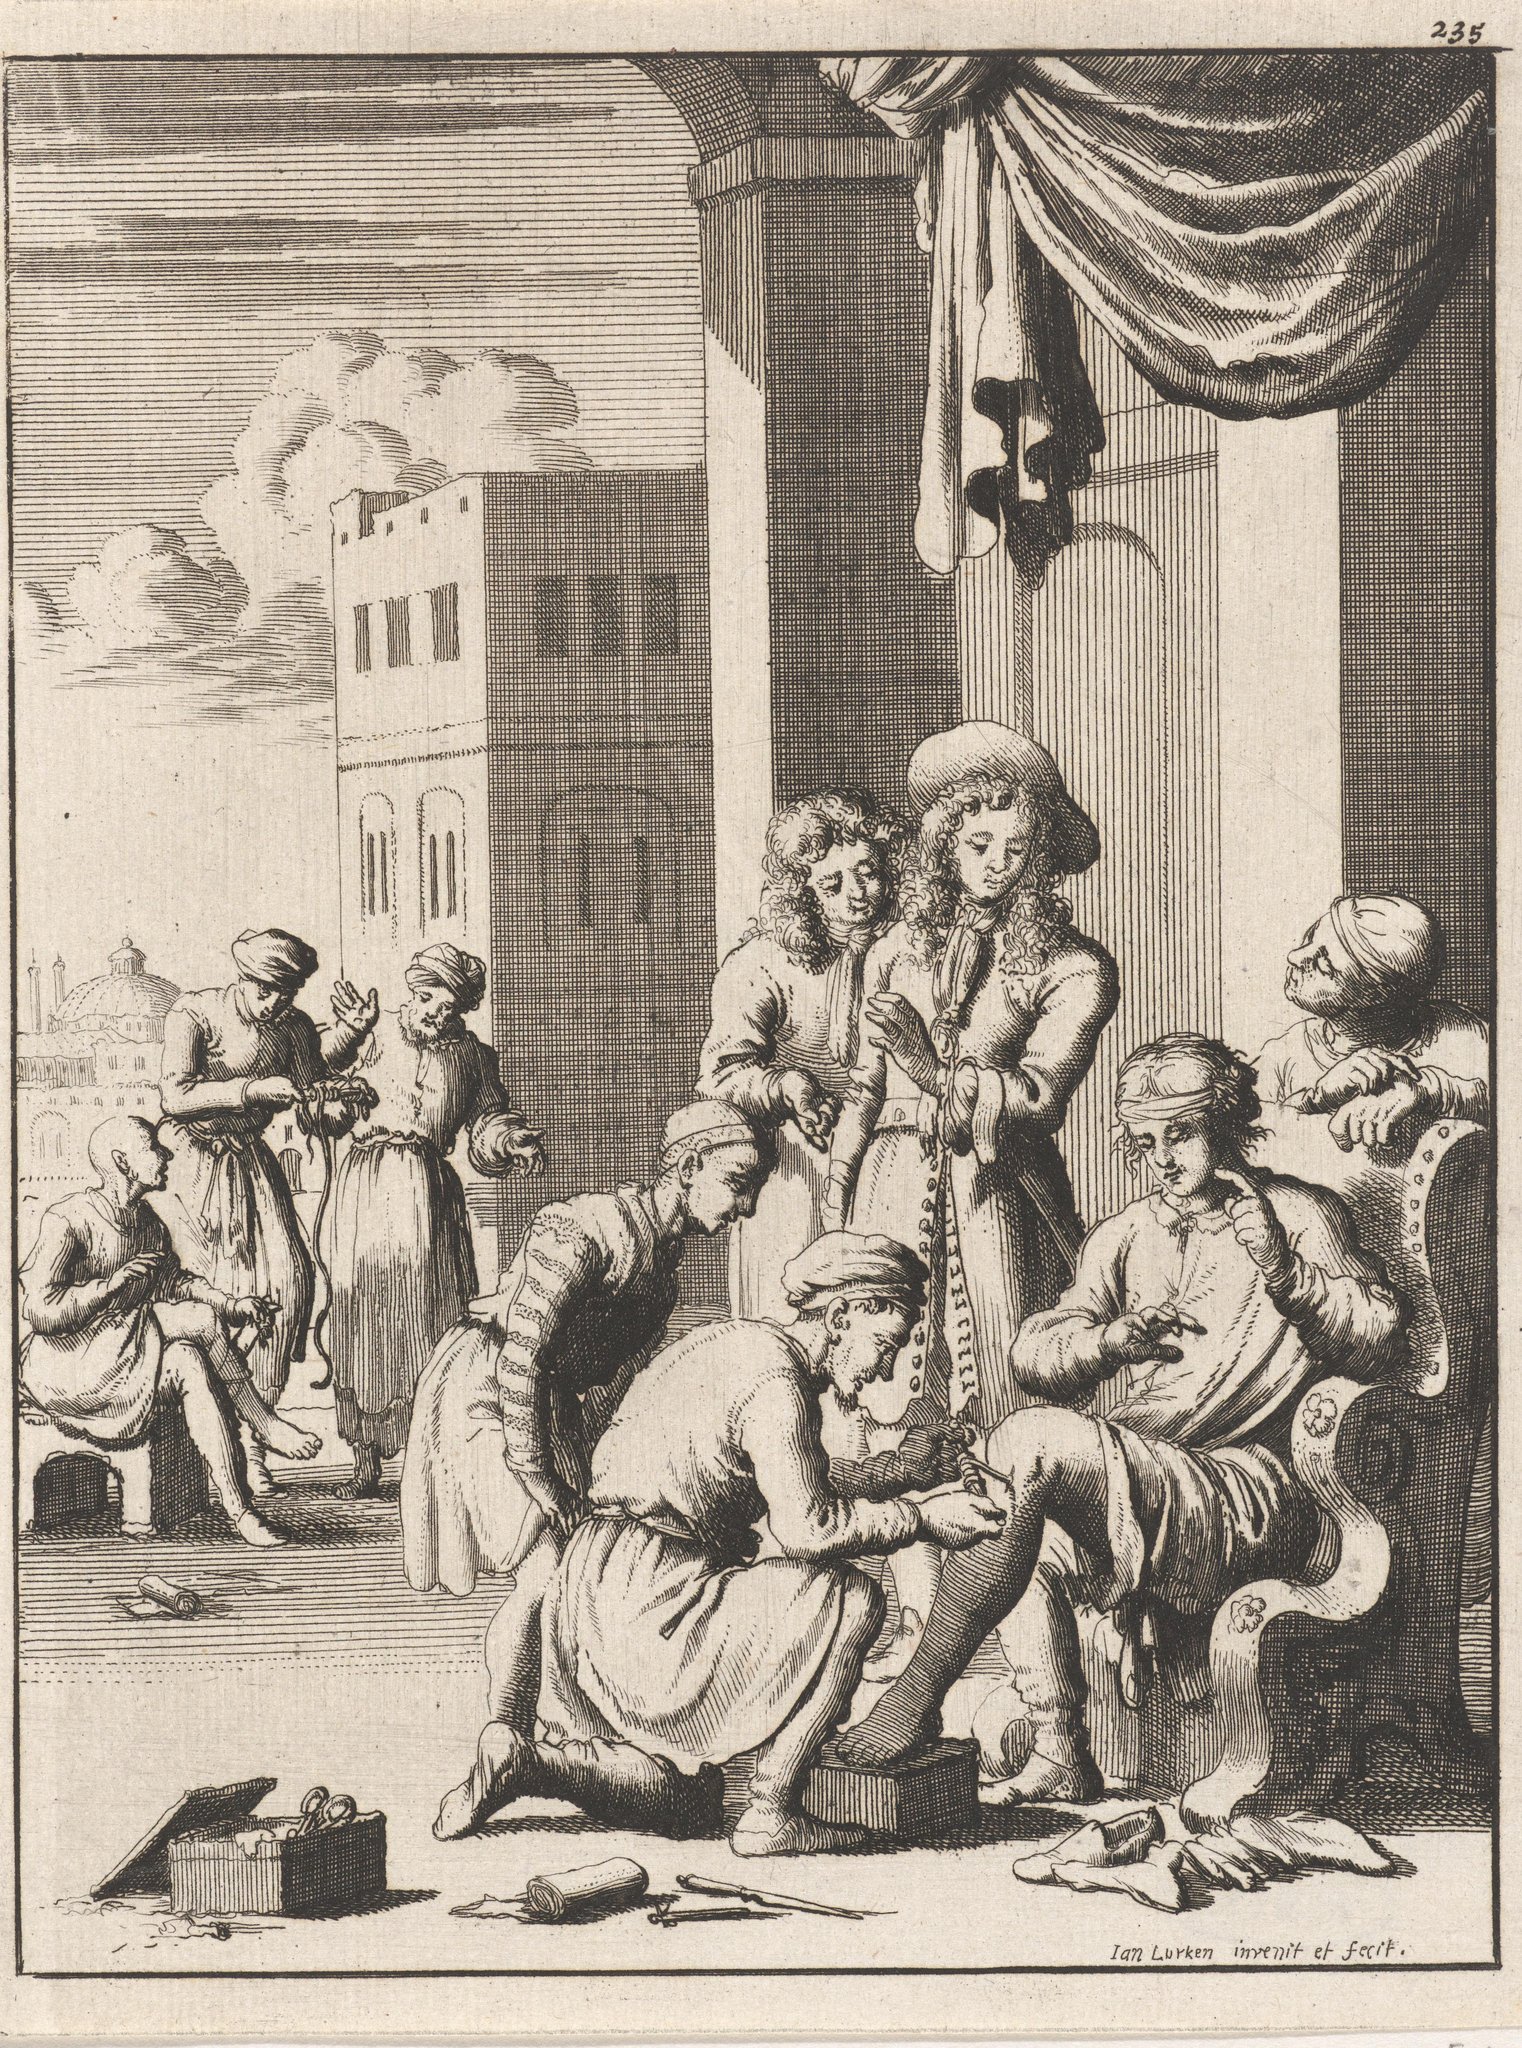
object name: print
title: Operatie ter verwijdering van wormen uit het been te Bender-Abassi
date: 1682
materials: paper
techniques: etching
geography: amsterdam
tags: worms, operation, surgery, persia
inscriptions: collector's mark: Lugt 2228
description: Illustratie opgenomen in deel II van: Thevenot, Jean de. Gedenkwaardige en zeer naauwkeurige reizen van den heere de Thevenot. Amsterdam: Jan Bouman, 1681-1682.